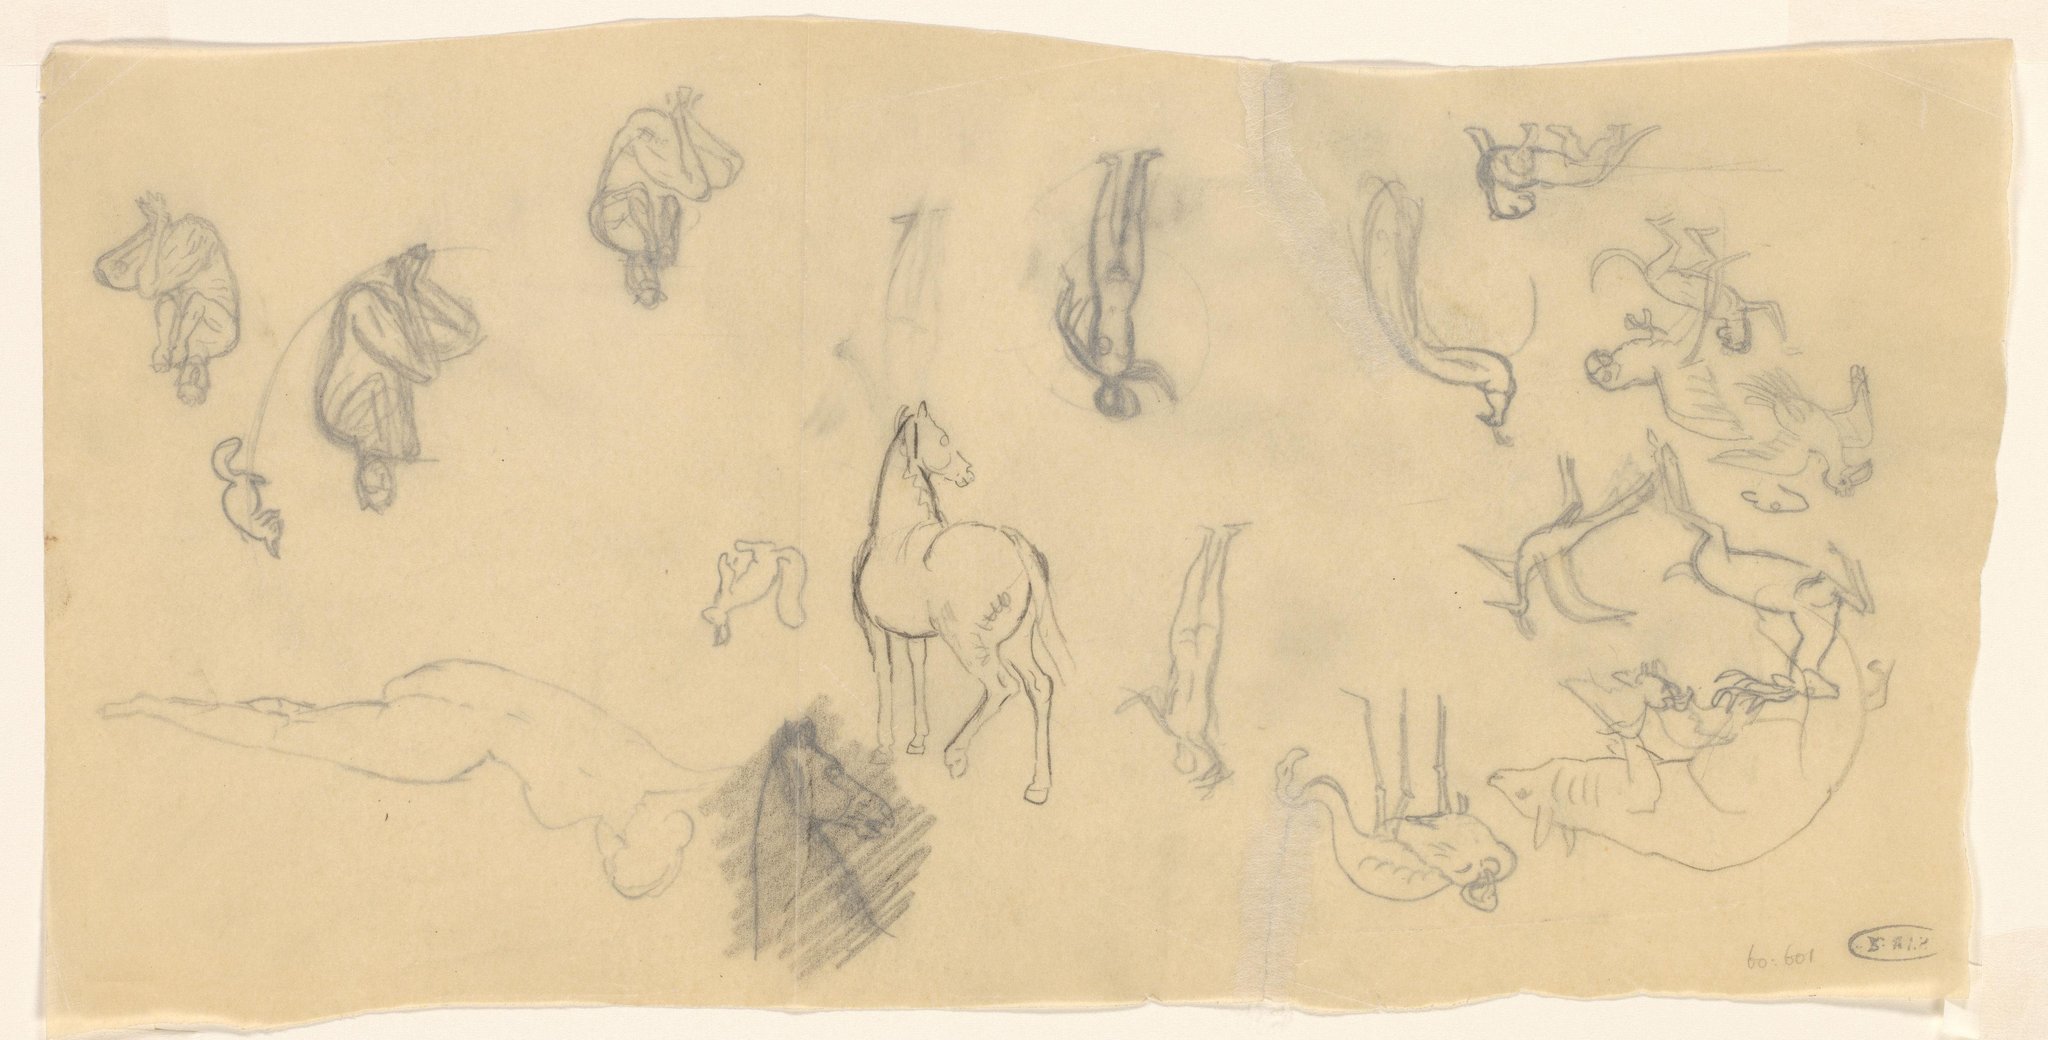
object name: drawing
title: Studieblad met dieren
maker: leo gestel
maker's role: draughtsman, print maker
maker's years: 1881-1941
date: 1891-1941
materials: pencil, paper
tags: horse, beasts of prey, predatory animals: fox